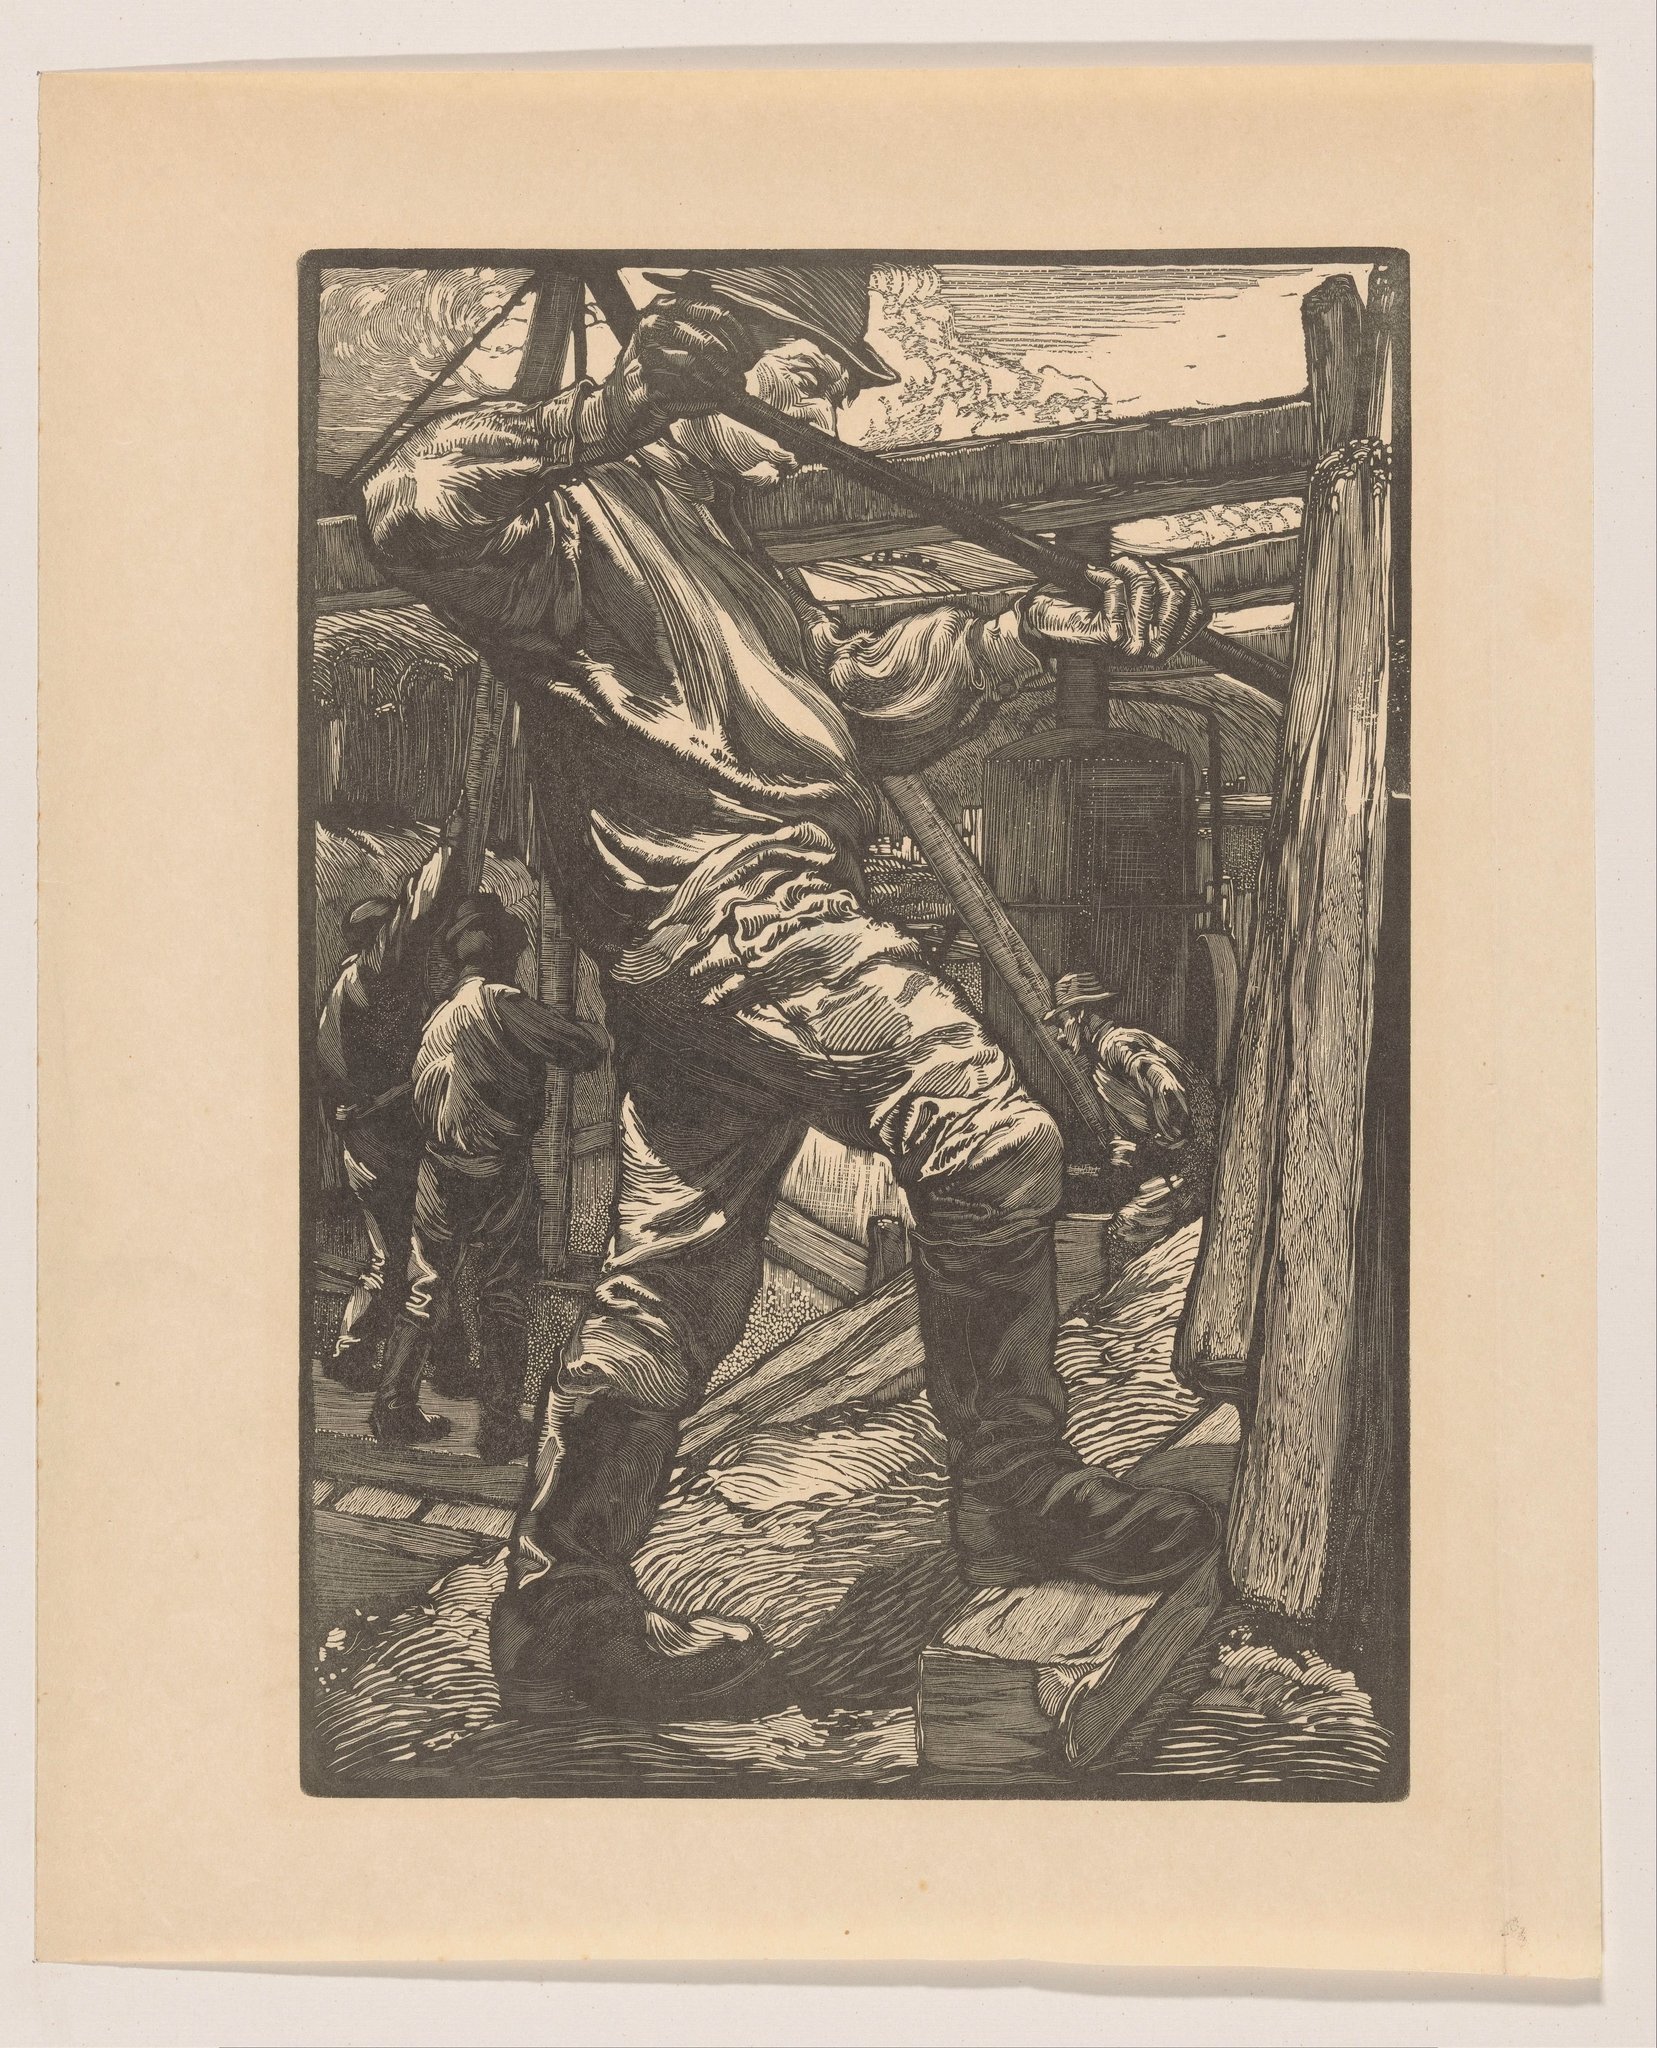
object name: print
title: Grondwerker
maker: johannes josephus aarts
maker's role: draughtsman, print maker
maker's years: 1871-1934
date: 1881-1934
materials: paper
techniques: woodcut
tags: working class, labourers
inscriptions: collector's mark: Lugt 2166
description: Een arbeider wrikt met een staaf tussen een stel balken. Op de achtergrond nog drie arbeiders, een bouwskelet en een machine.